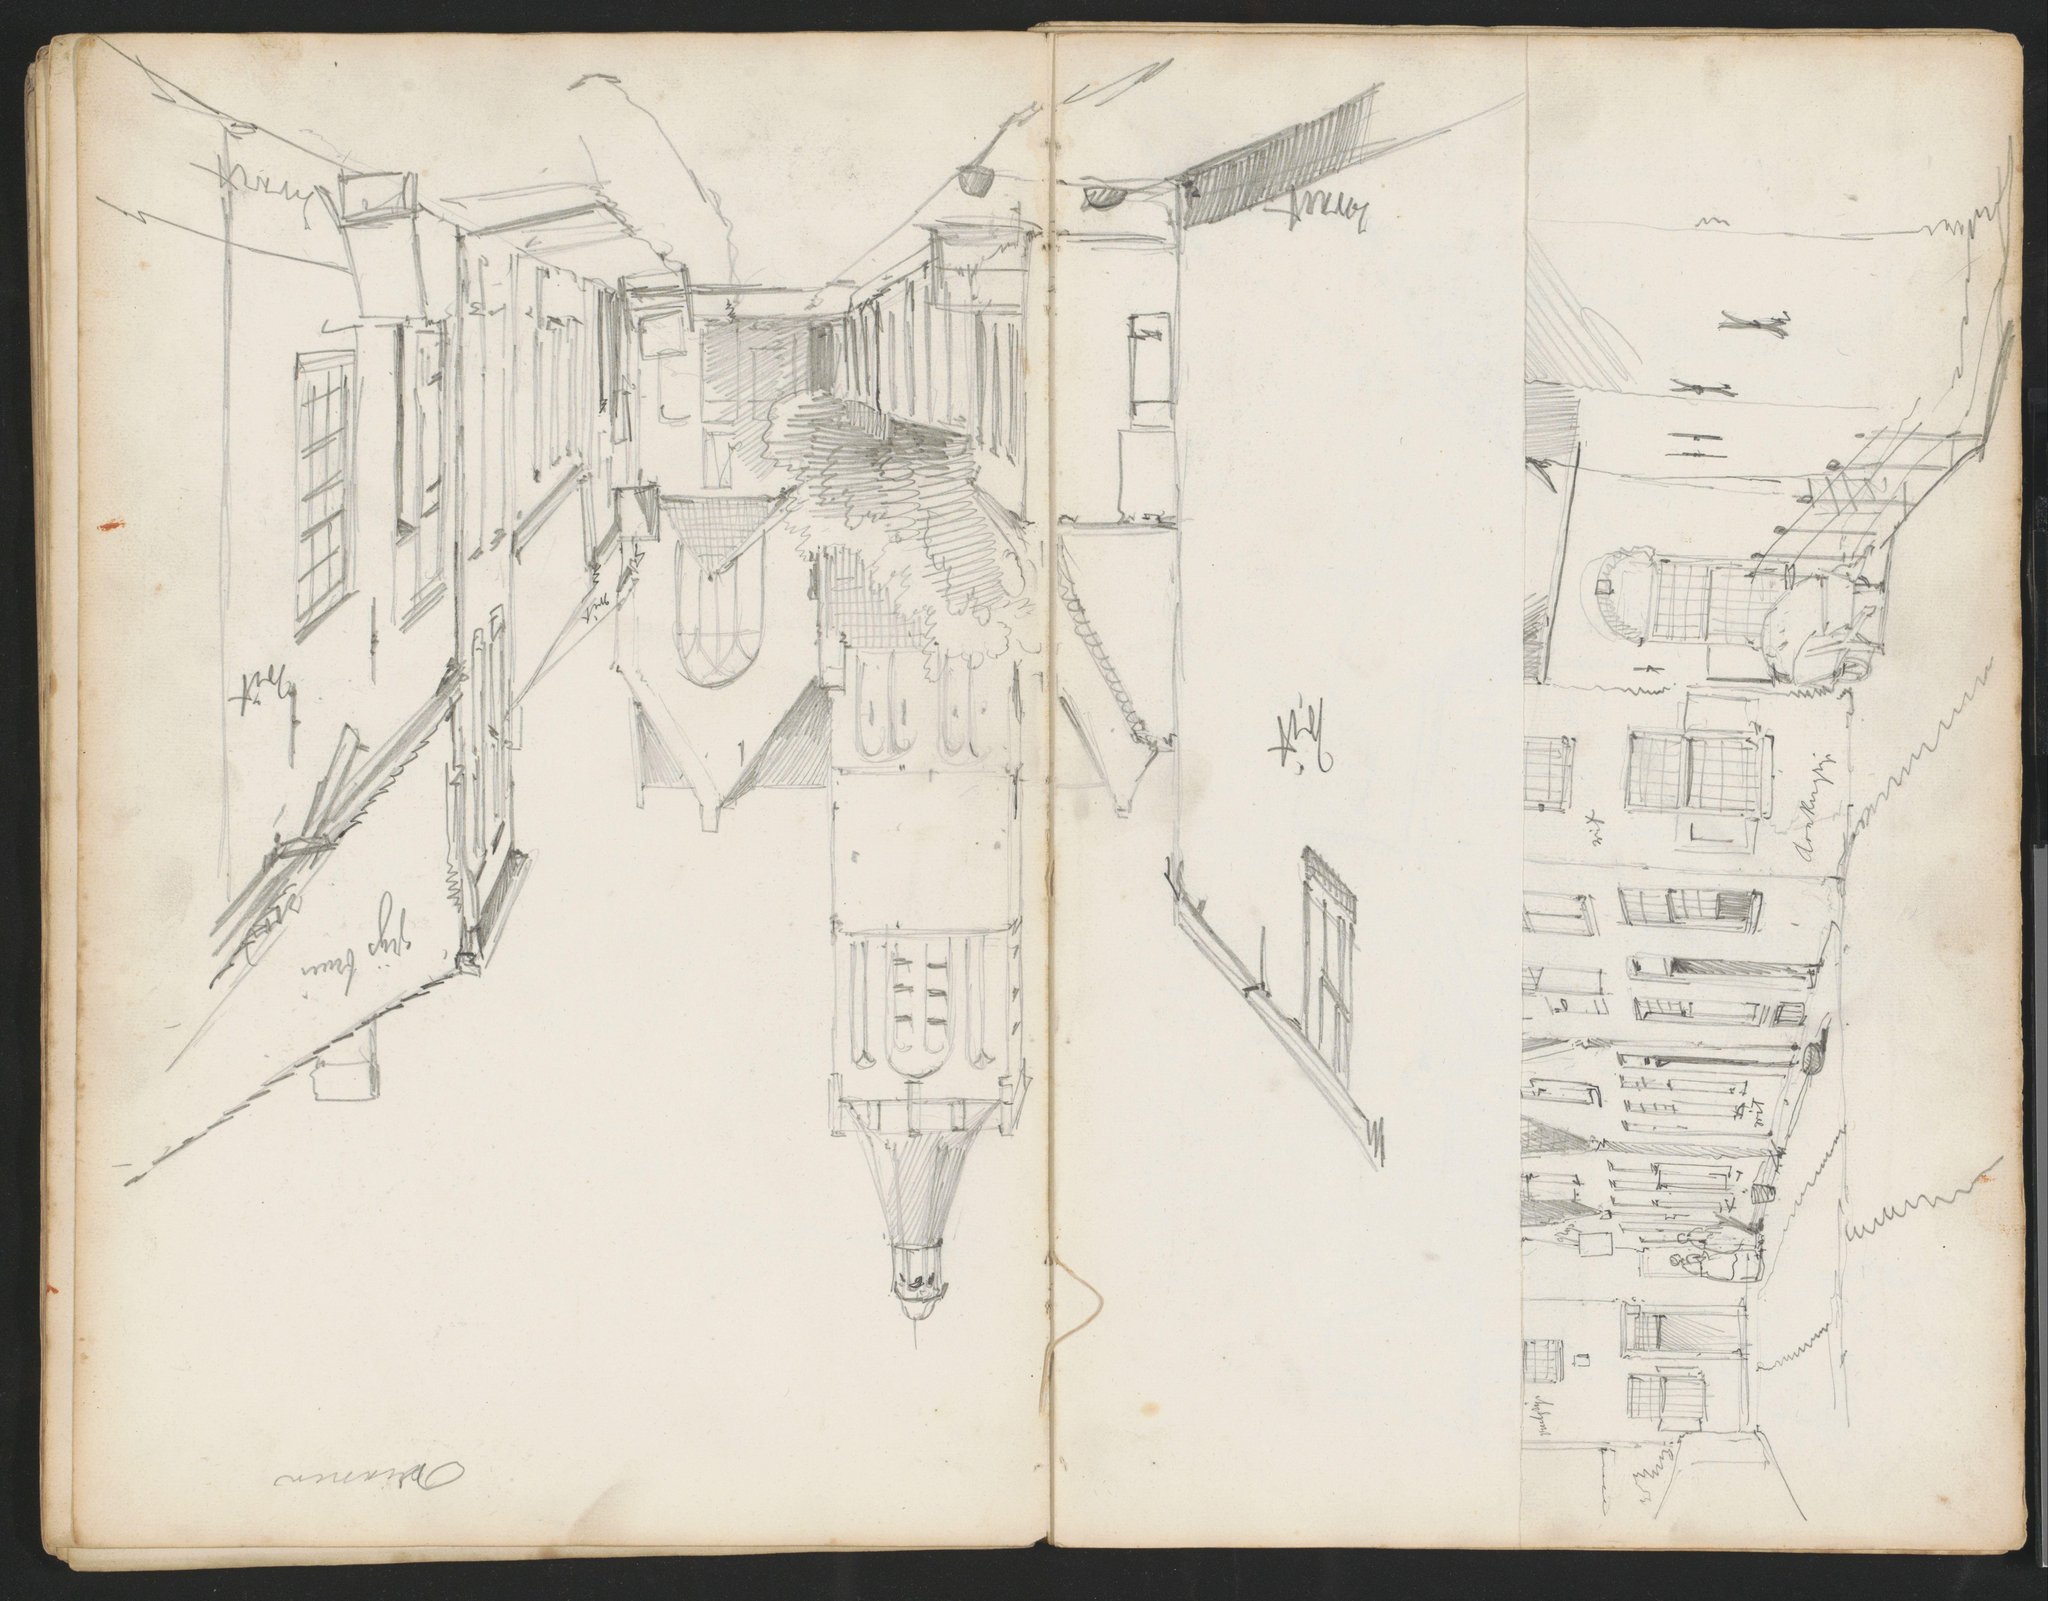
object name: sketchbook leaf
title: Straatgezicht met figuren en de Grote Kerk te Vianen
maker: willem koekkoek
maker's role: draughtsman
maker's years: 1839-1895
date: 1849-1895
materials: paper, pencil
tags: church (exterior), street (+ city(-scape) with figures, staffage)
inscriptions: annotation: ‘Vianen’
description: Blad 21 verso en 22 recto uit een schetsboek met 42 bladen.